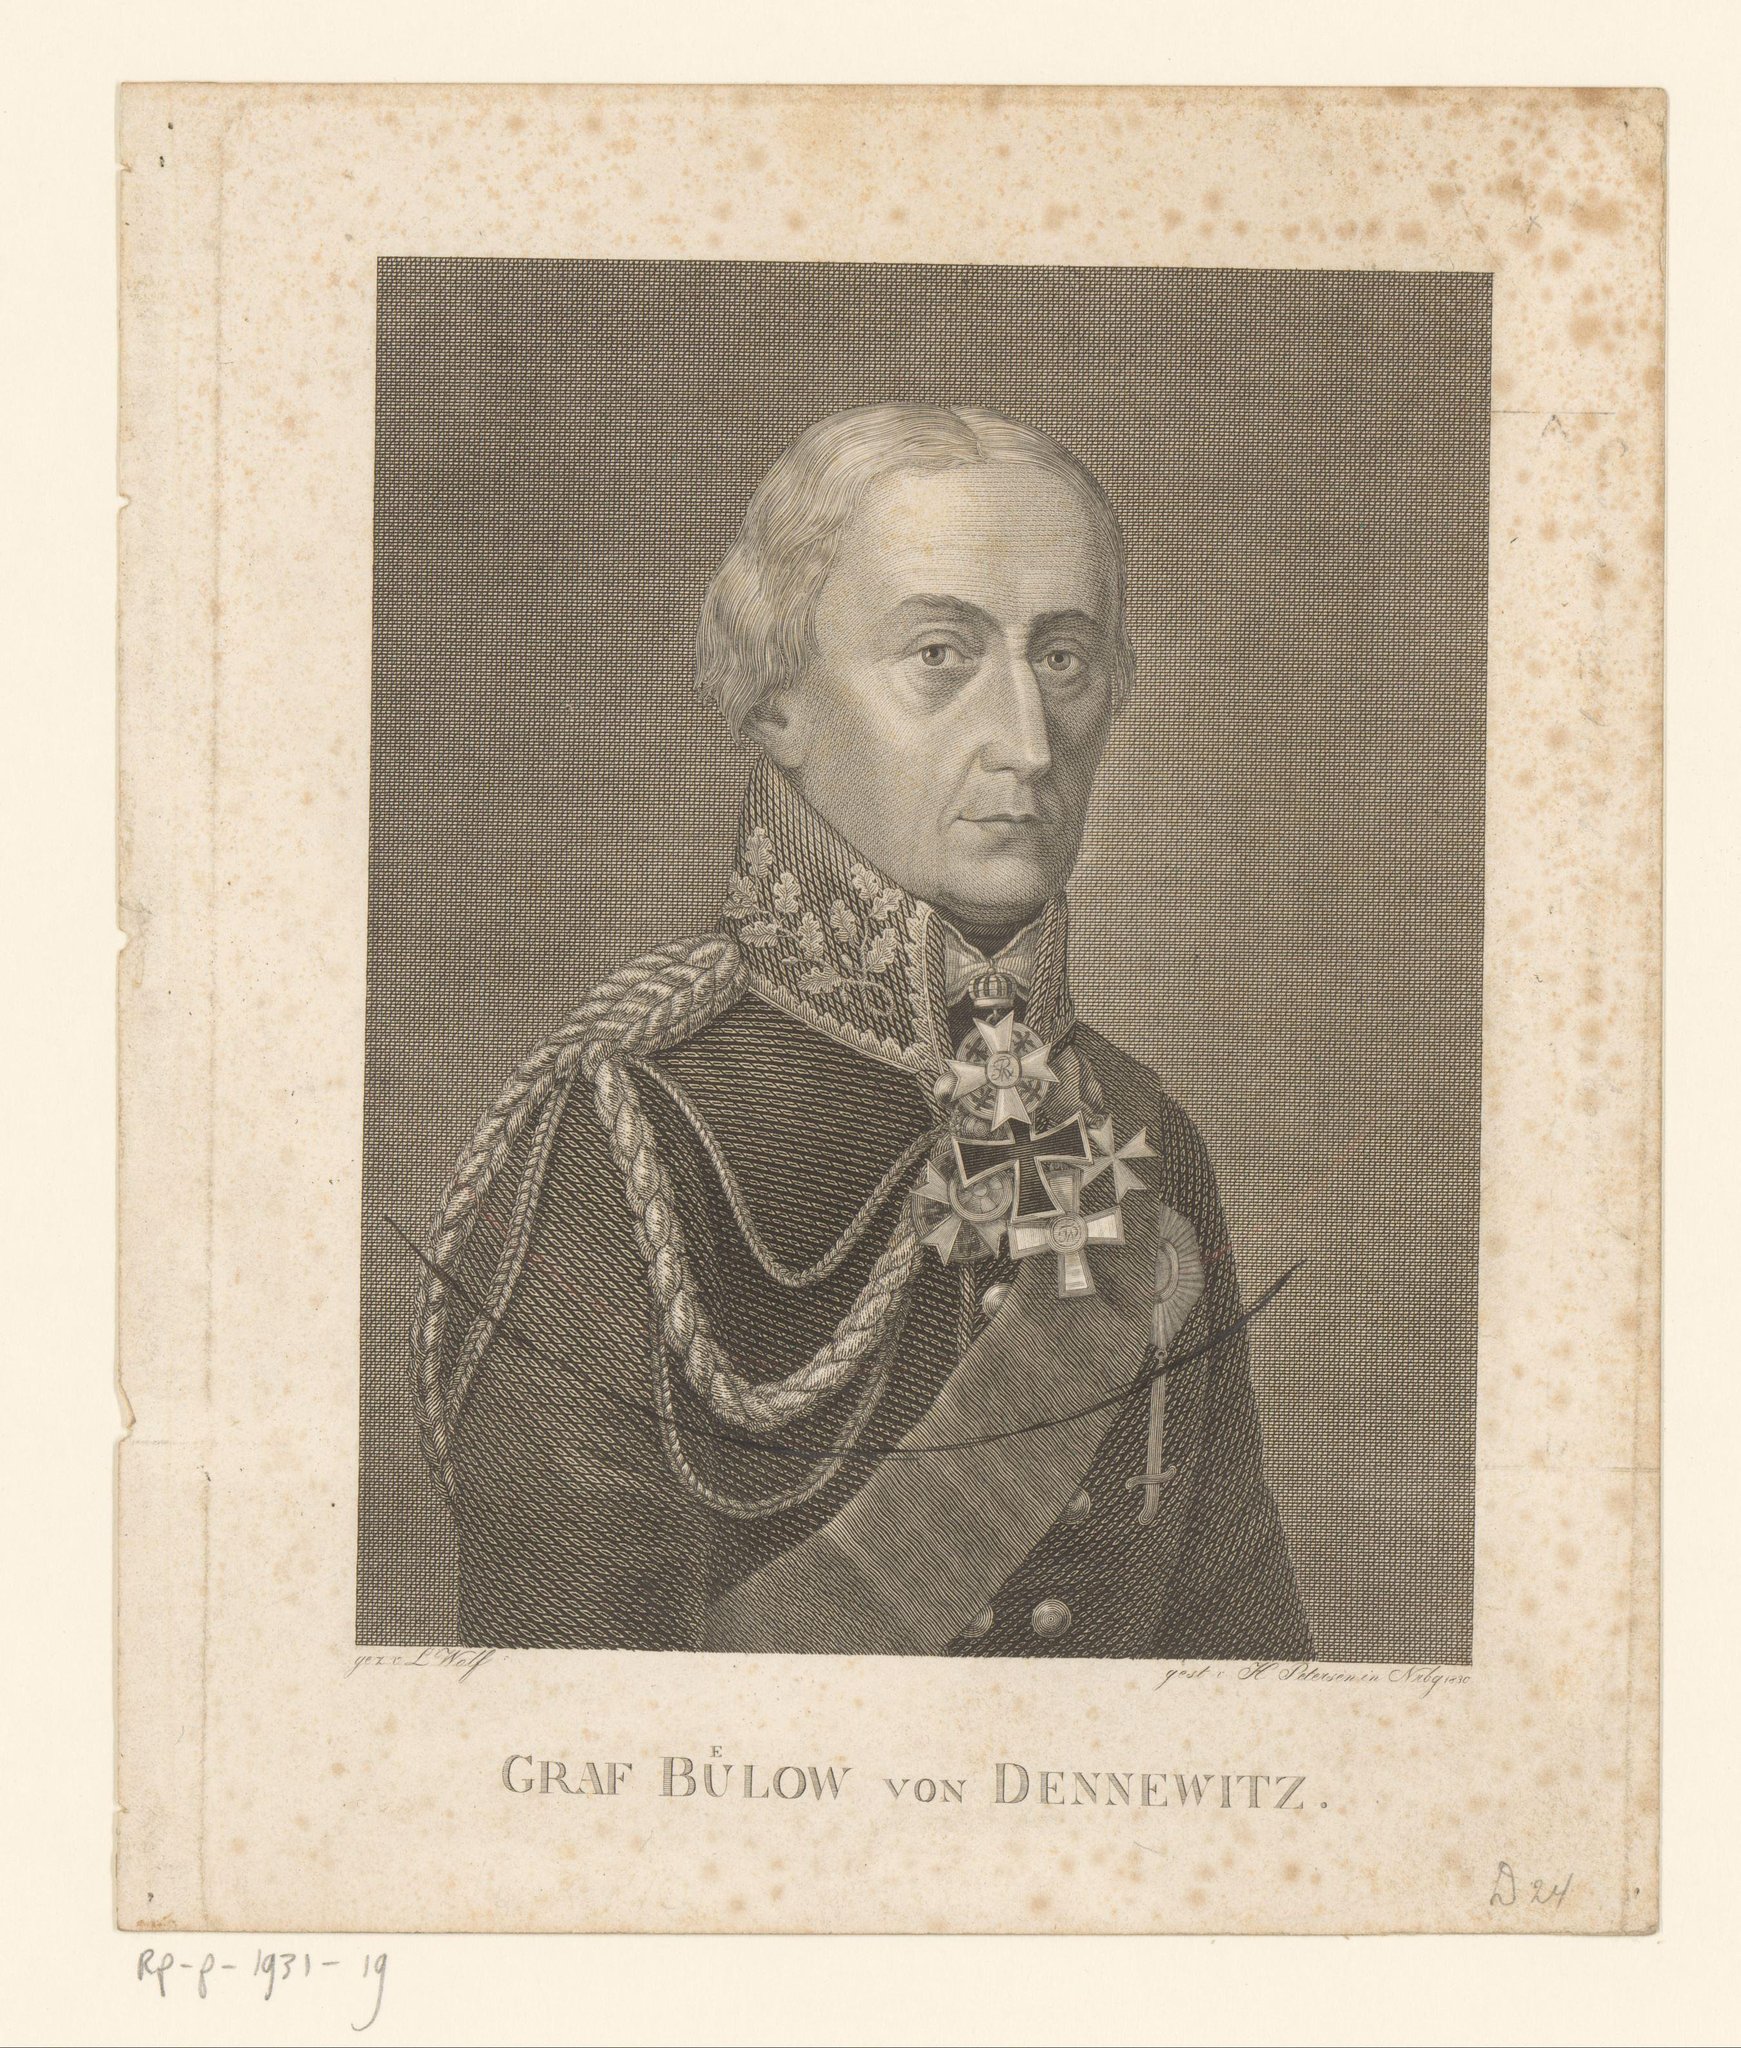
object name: print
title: Portret van Friedrich Wilhelm, graaf Bülow van Dennewitz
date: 1821-1874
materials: paper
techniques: engraving, etching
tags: historical persons, medals and other marks of military honour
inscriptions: collector's mark: Lugt 2228